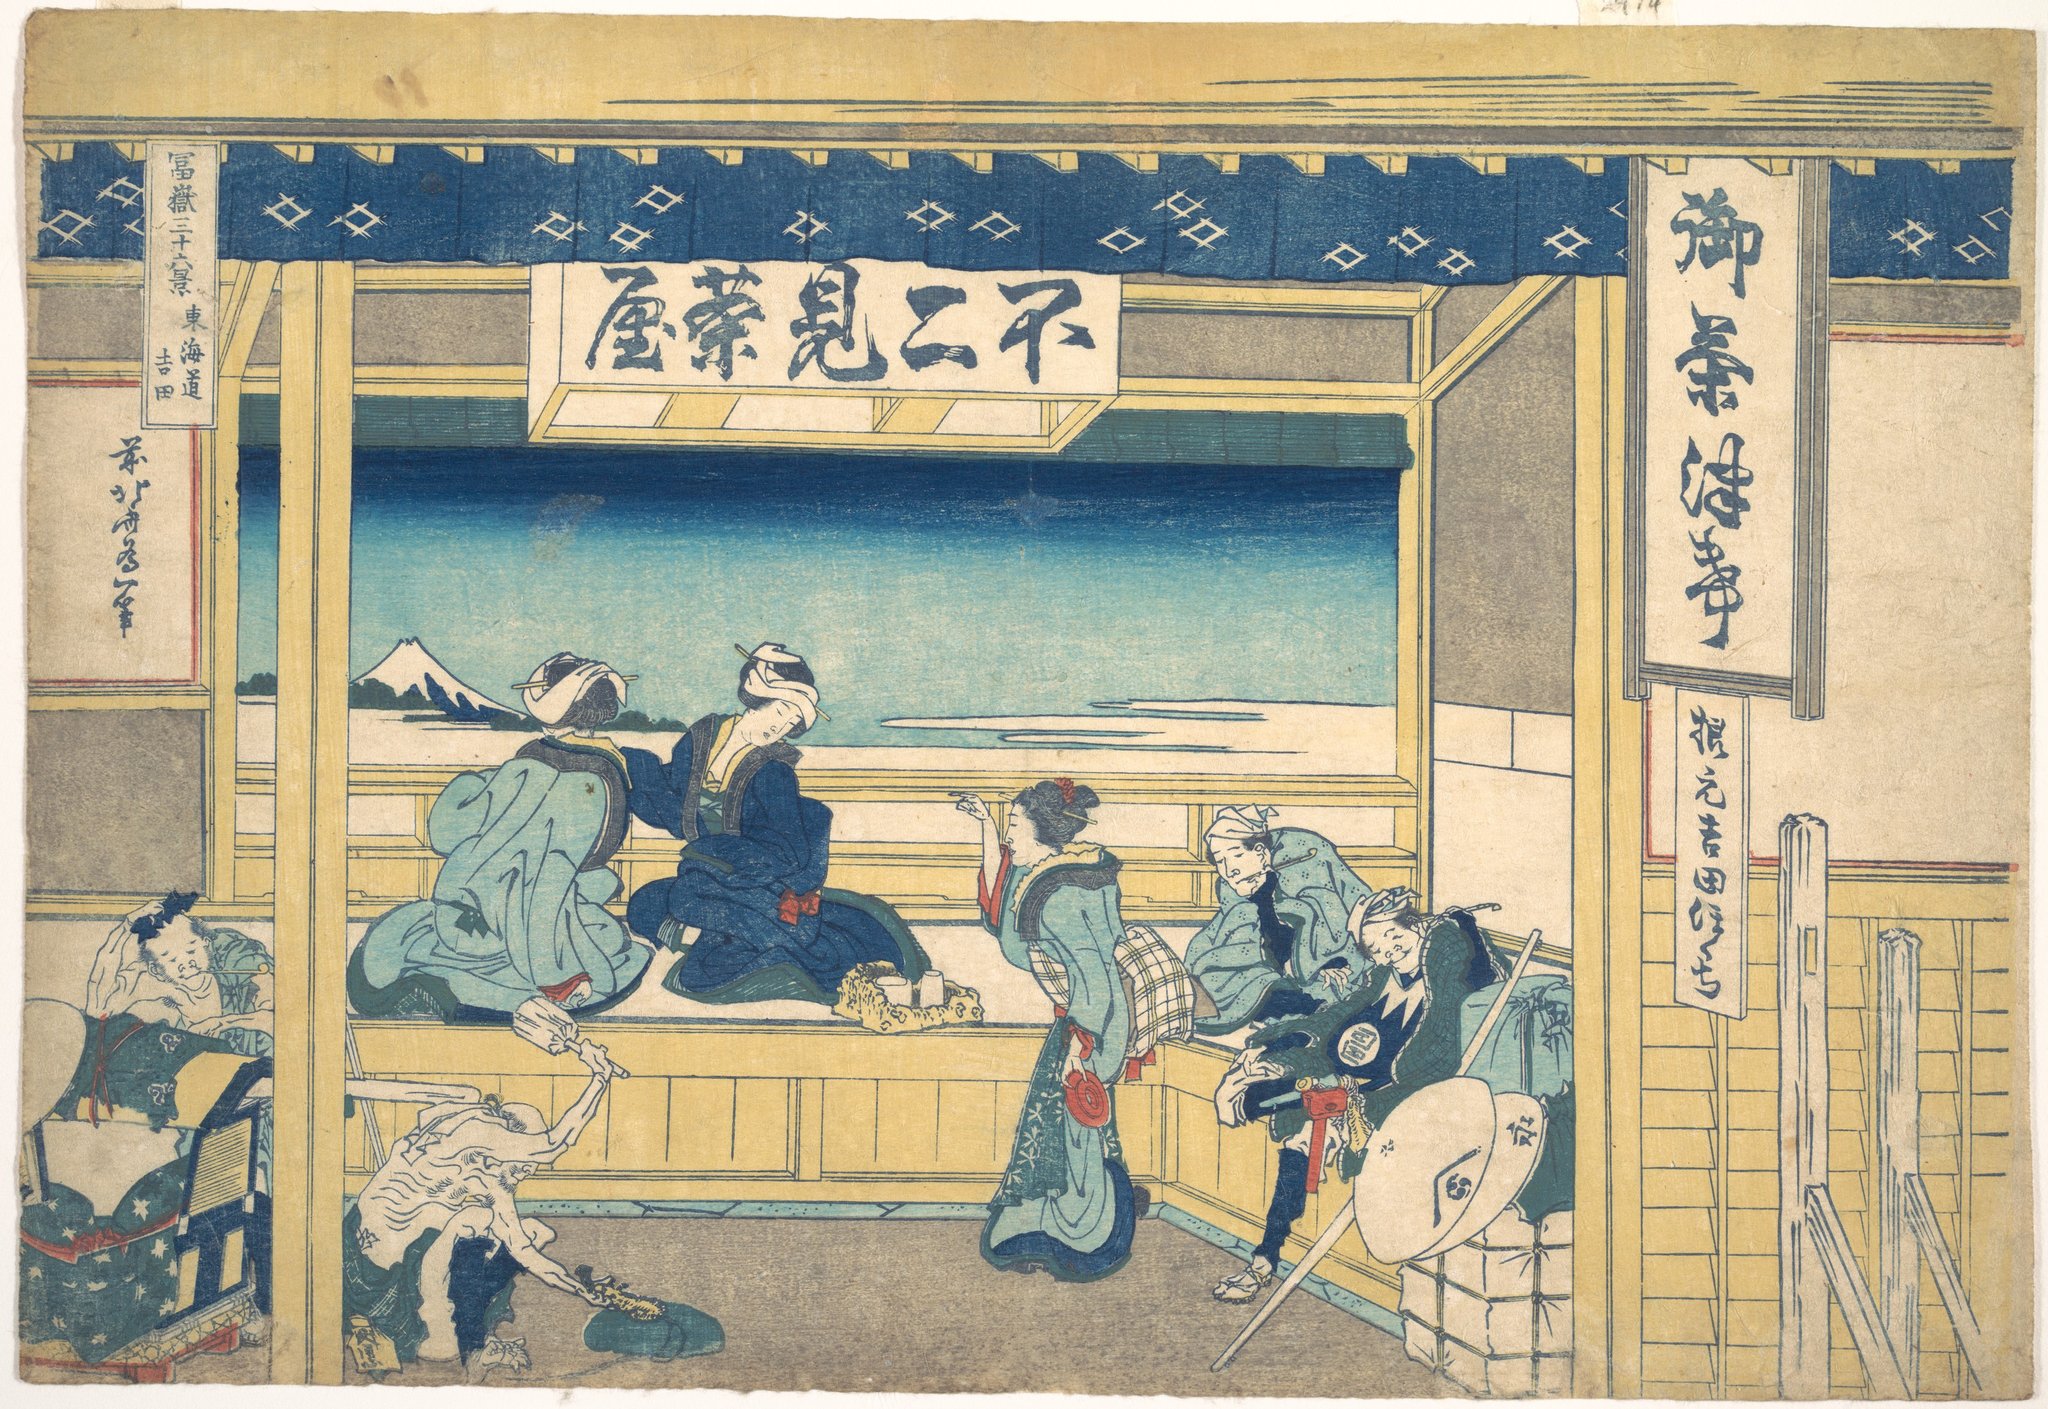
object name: woodblock print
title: Yoshida on the Tōkaidō (Tōkaidō Yoshida), from the series Thirty-six Views of Mount Fuji (Fugaku sanjūrokkei)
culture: japanese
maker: katsushika hokusai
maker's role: artist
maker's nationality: japanese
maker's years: 1760-1849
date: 1830-1832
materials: ink, paper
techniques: woodblock print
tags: men,women,tea houses